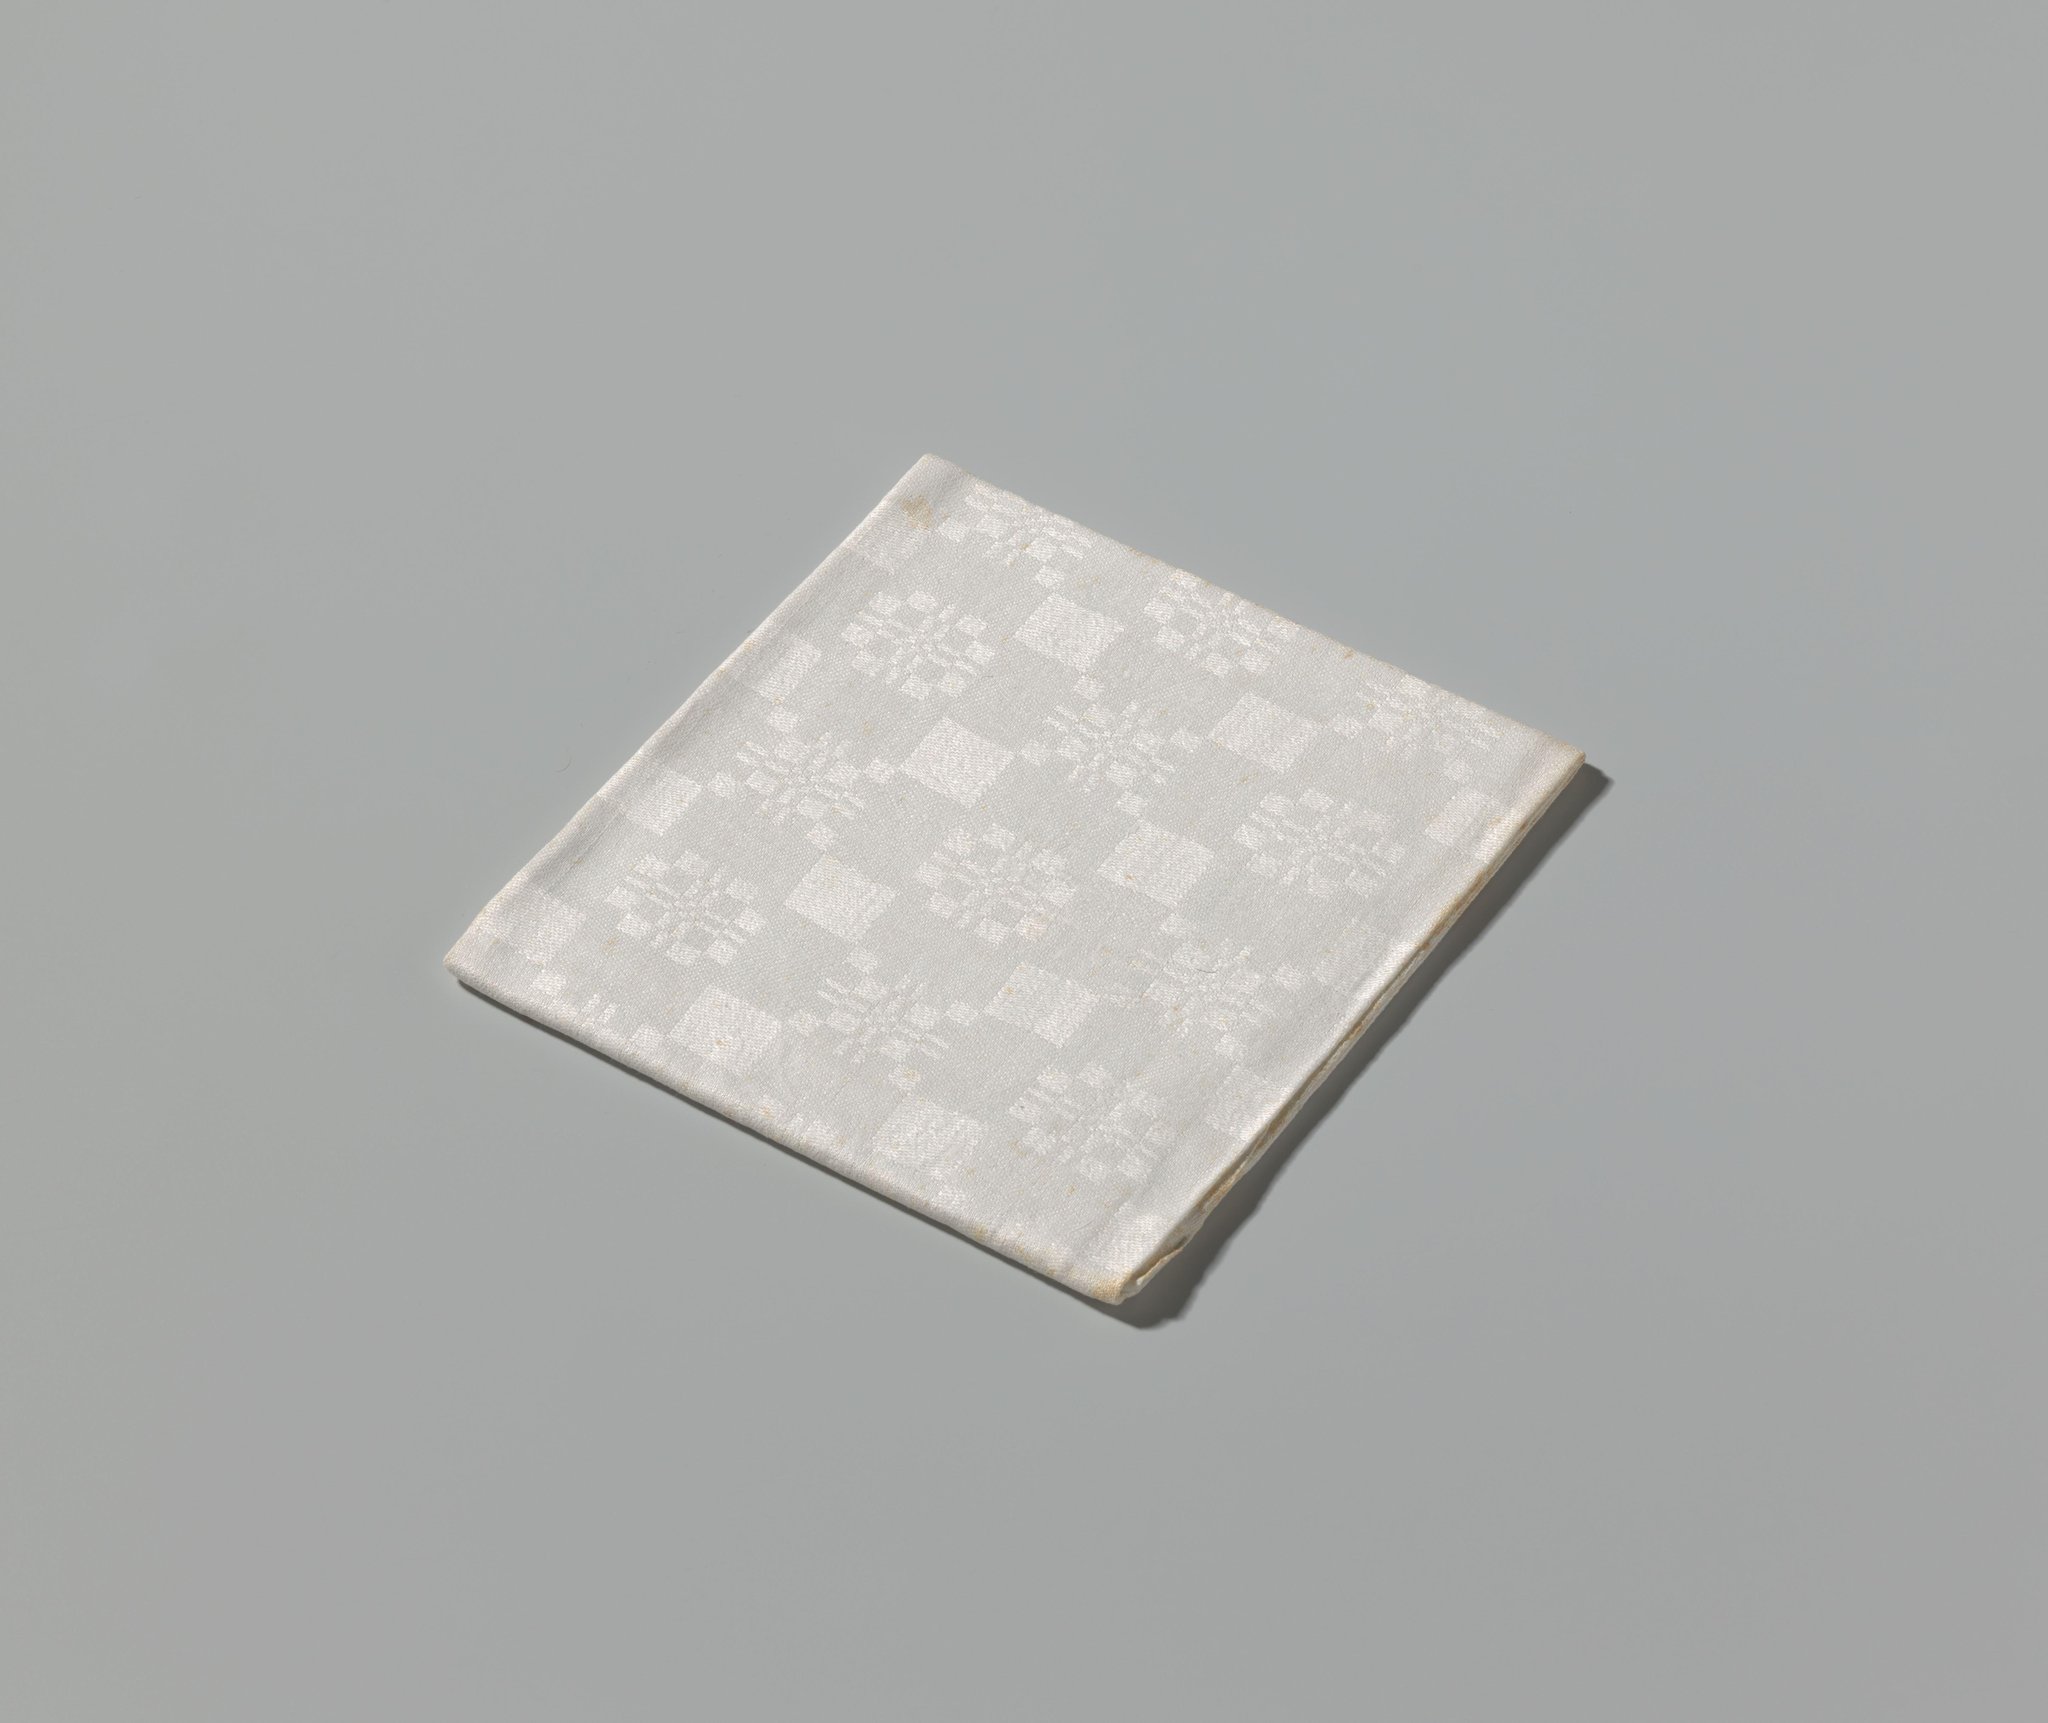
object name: towel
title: Handdoek van pellendamast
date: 1800-1900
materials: linen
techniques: cross stitching, weave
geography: north brabant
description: Handdoek van linnen pellendamast. Het geblokte veld heeft rijen met effen vierkanten die afgewisseld worden door rijen met vierkanten die uit kleinere blokken zijn opgebouwd. De randen zijn gestreept. De handdoek is gemerkt in rood met een kruissteek: G 24.